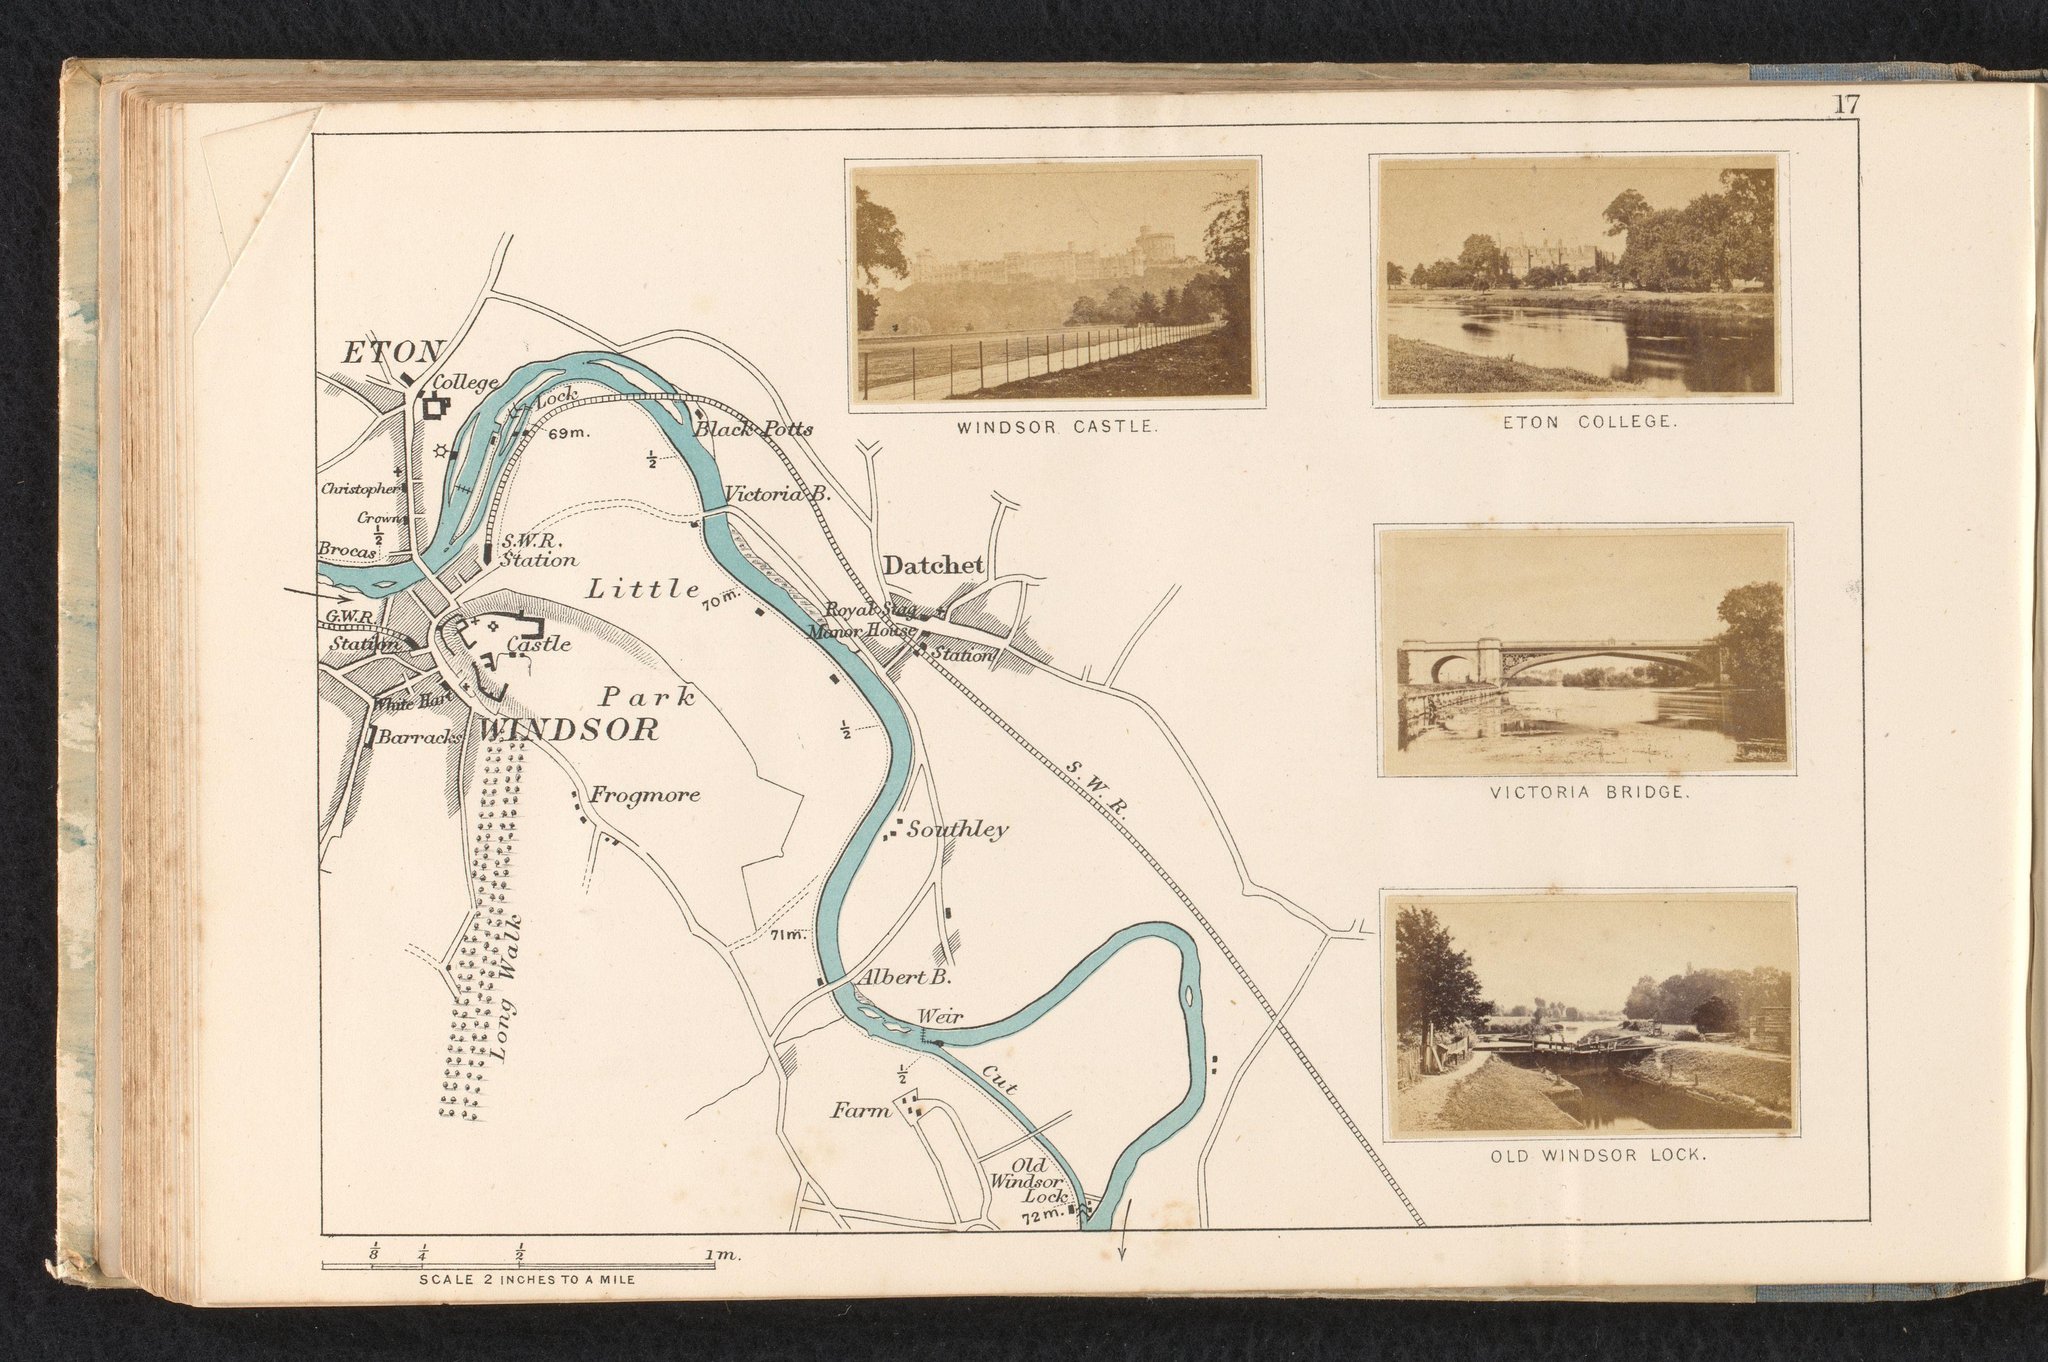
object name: page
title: Windsor Castle, Eton College, Victoria Bridge, Old Windsor Lock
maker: Anonymous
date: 1868-1873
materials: paper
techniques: albumen print, letterpress printing, line block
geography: berkshire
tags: castle, landscapes in the temperate zone, river bank, landscape with bridge, viaduct or aqueduct, university building, college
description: Foto's op vierde ongenummerde pagina na pagina 32.